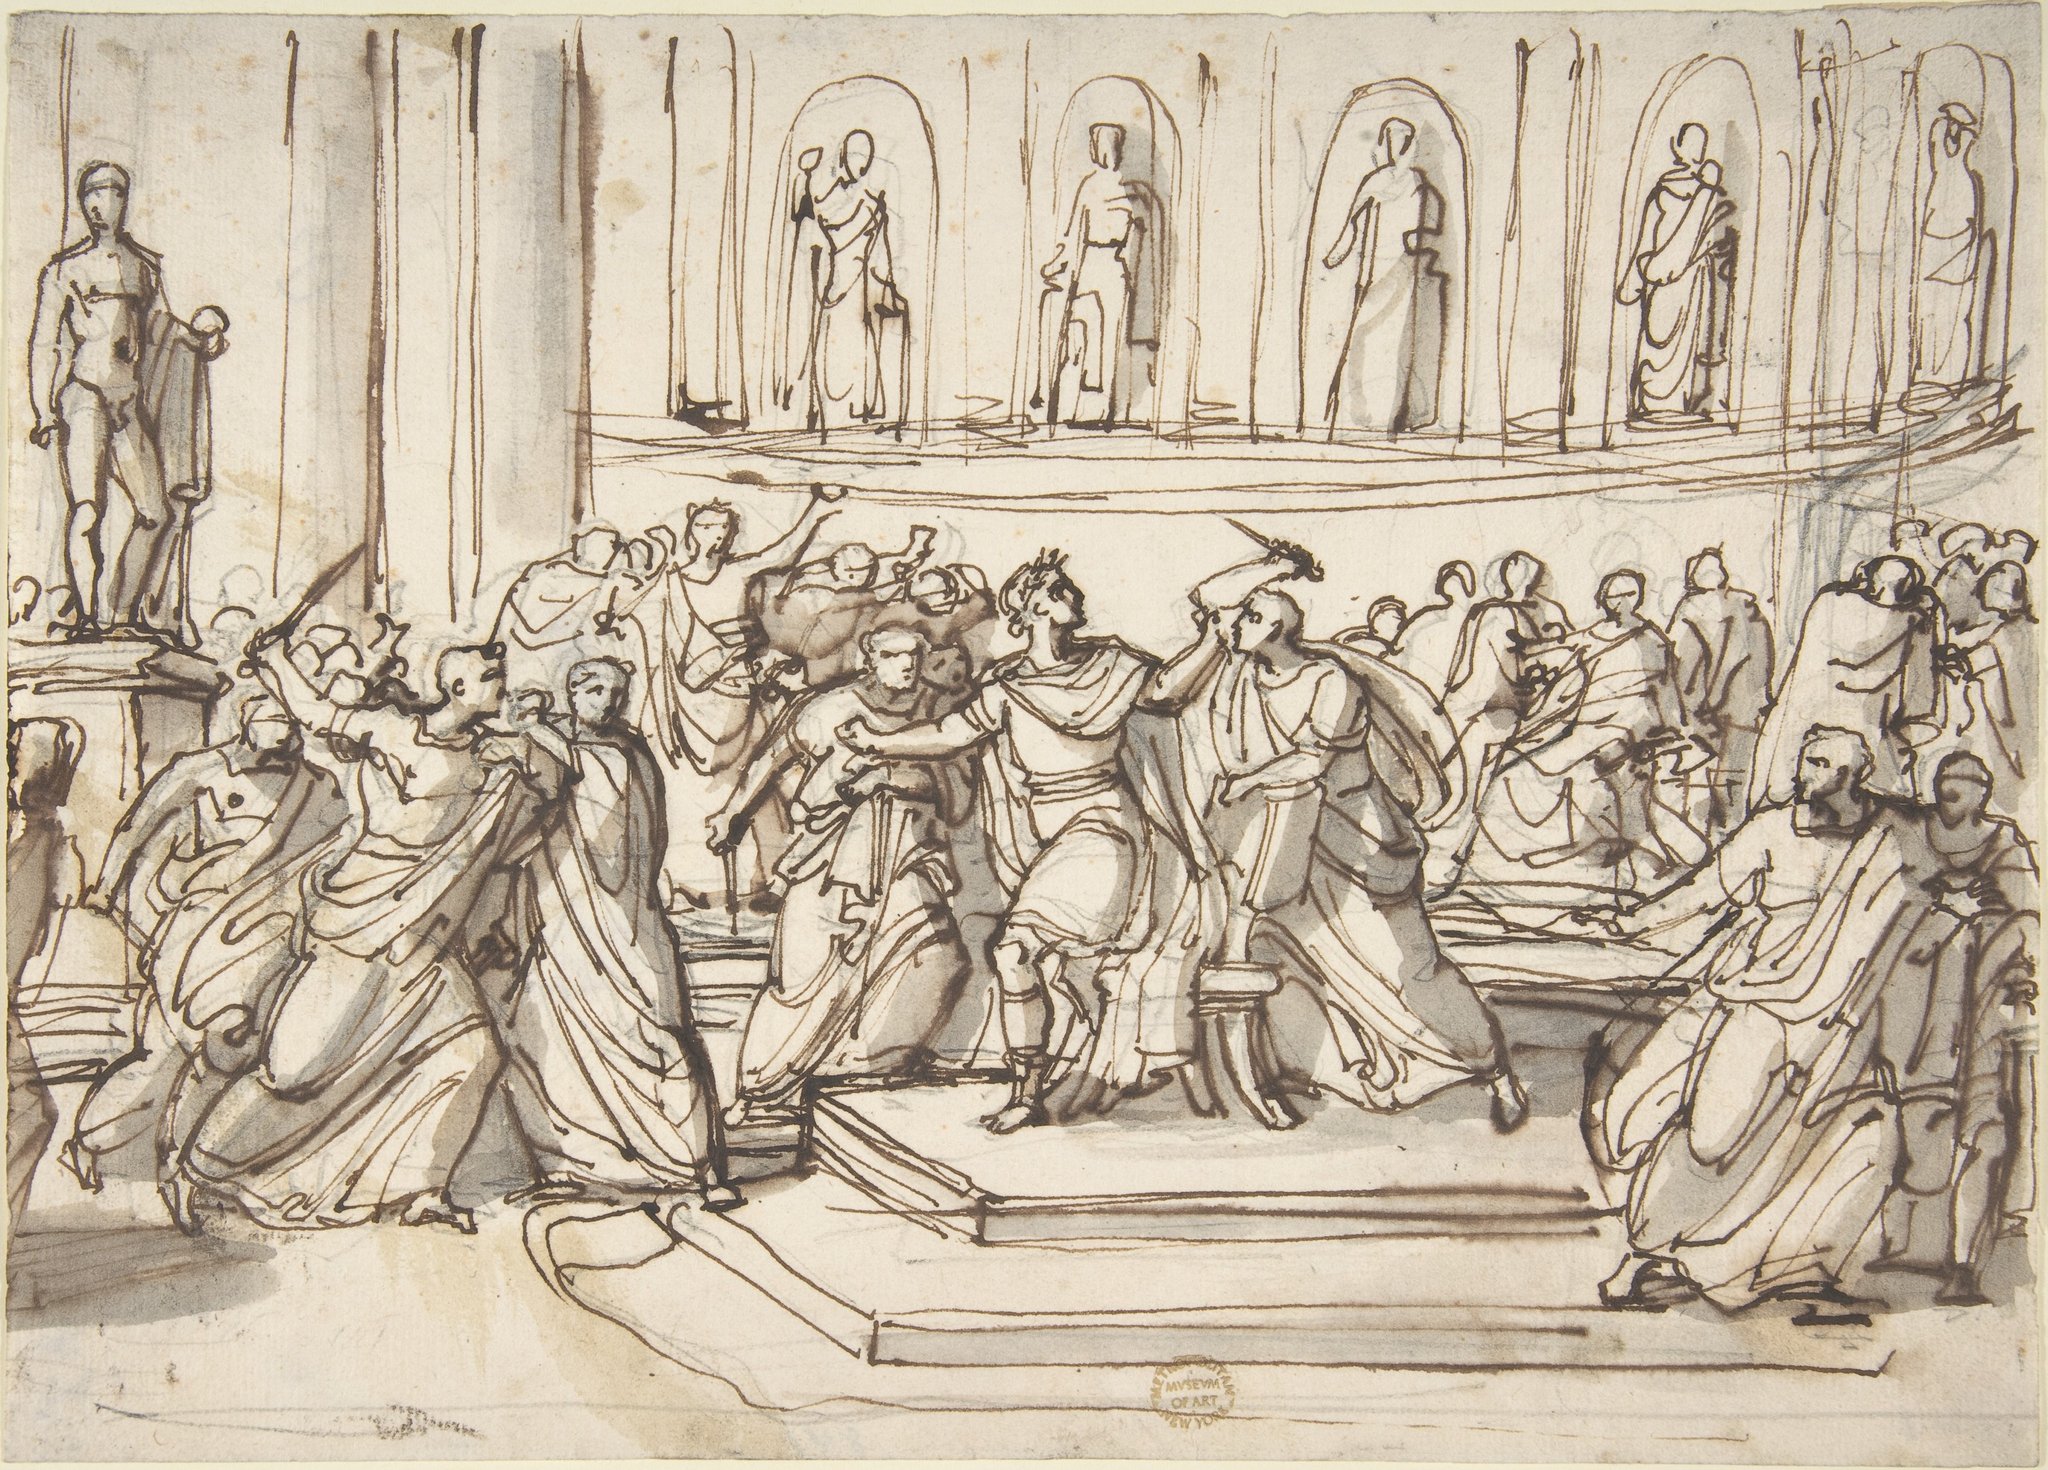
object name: drawing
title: Assassination of Julius Caesar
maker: vincenzo camuccini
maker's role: artist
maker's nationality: italian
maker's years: 1771-1844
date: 1793-1796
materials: graphite, ink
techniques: brush, pen, wash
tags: julius caesar,men